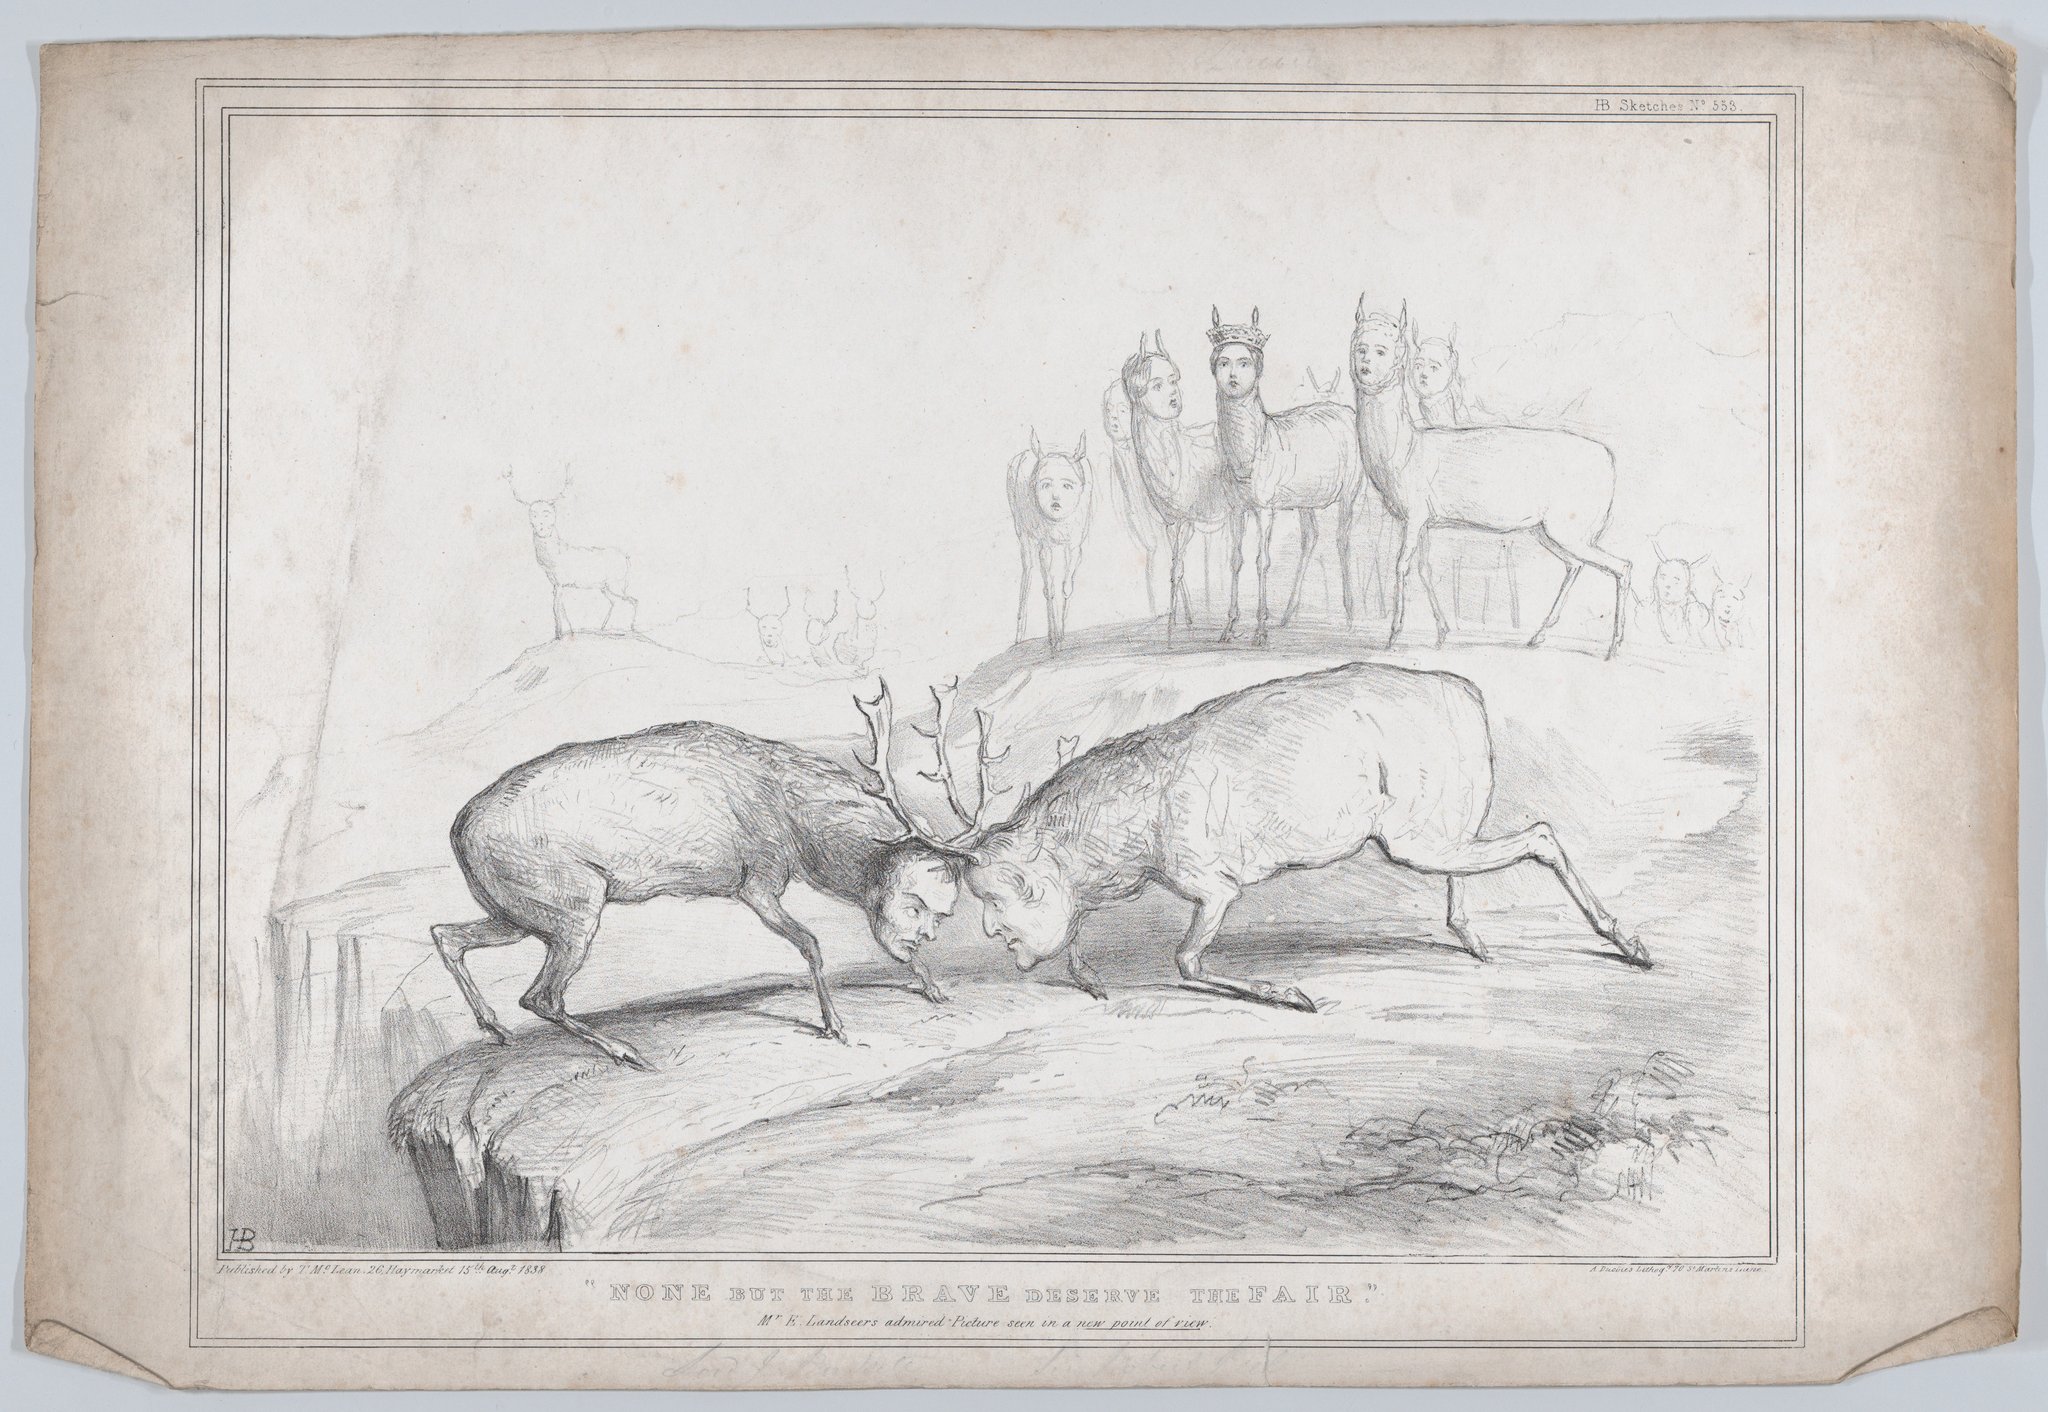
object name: print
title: "None But the Brave Deserve the Fair" – Mr. E. Landseer's admired Picture seen in a new point of view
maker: john doyle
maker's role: artist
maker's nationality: irish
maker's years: 1797-1868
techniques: lithograph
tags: caricature,politics,queen victoria